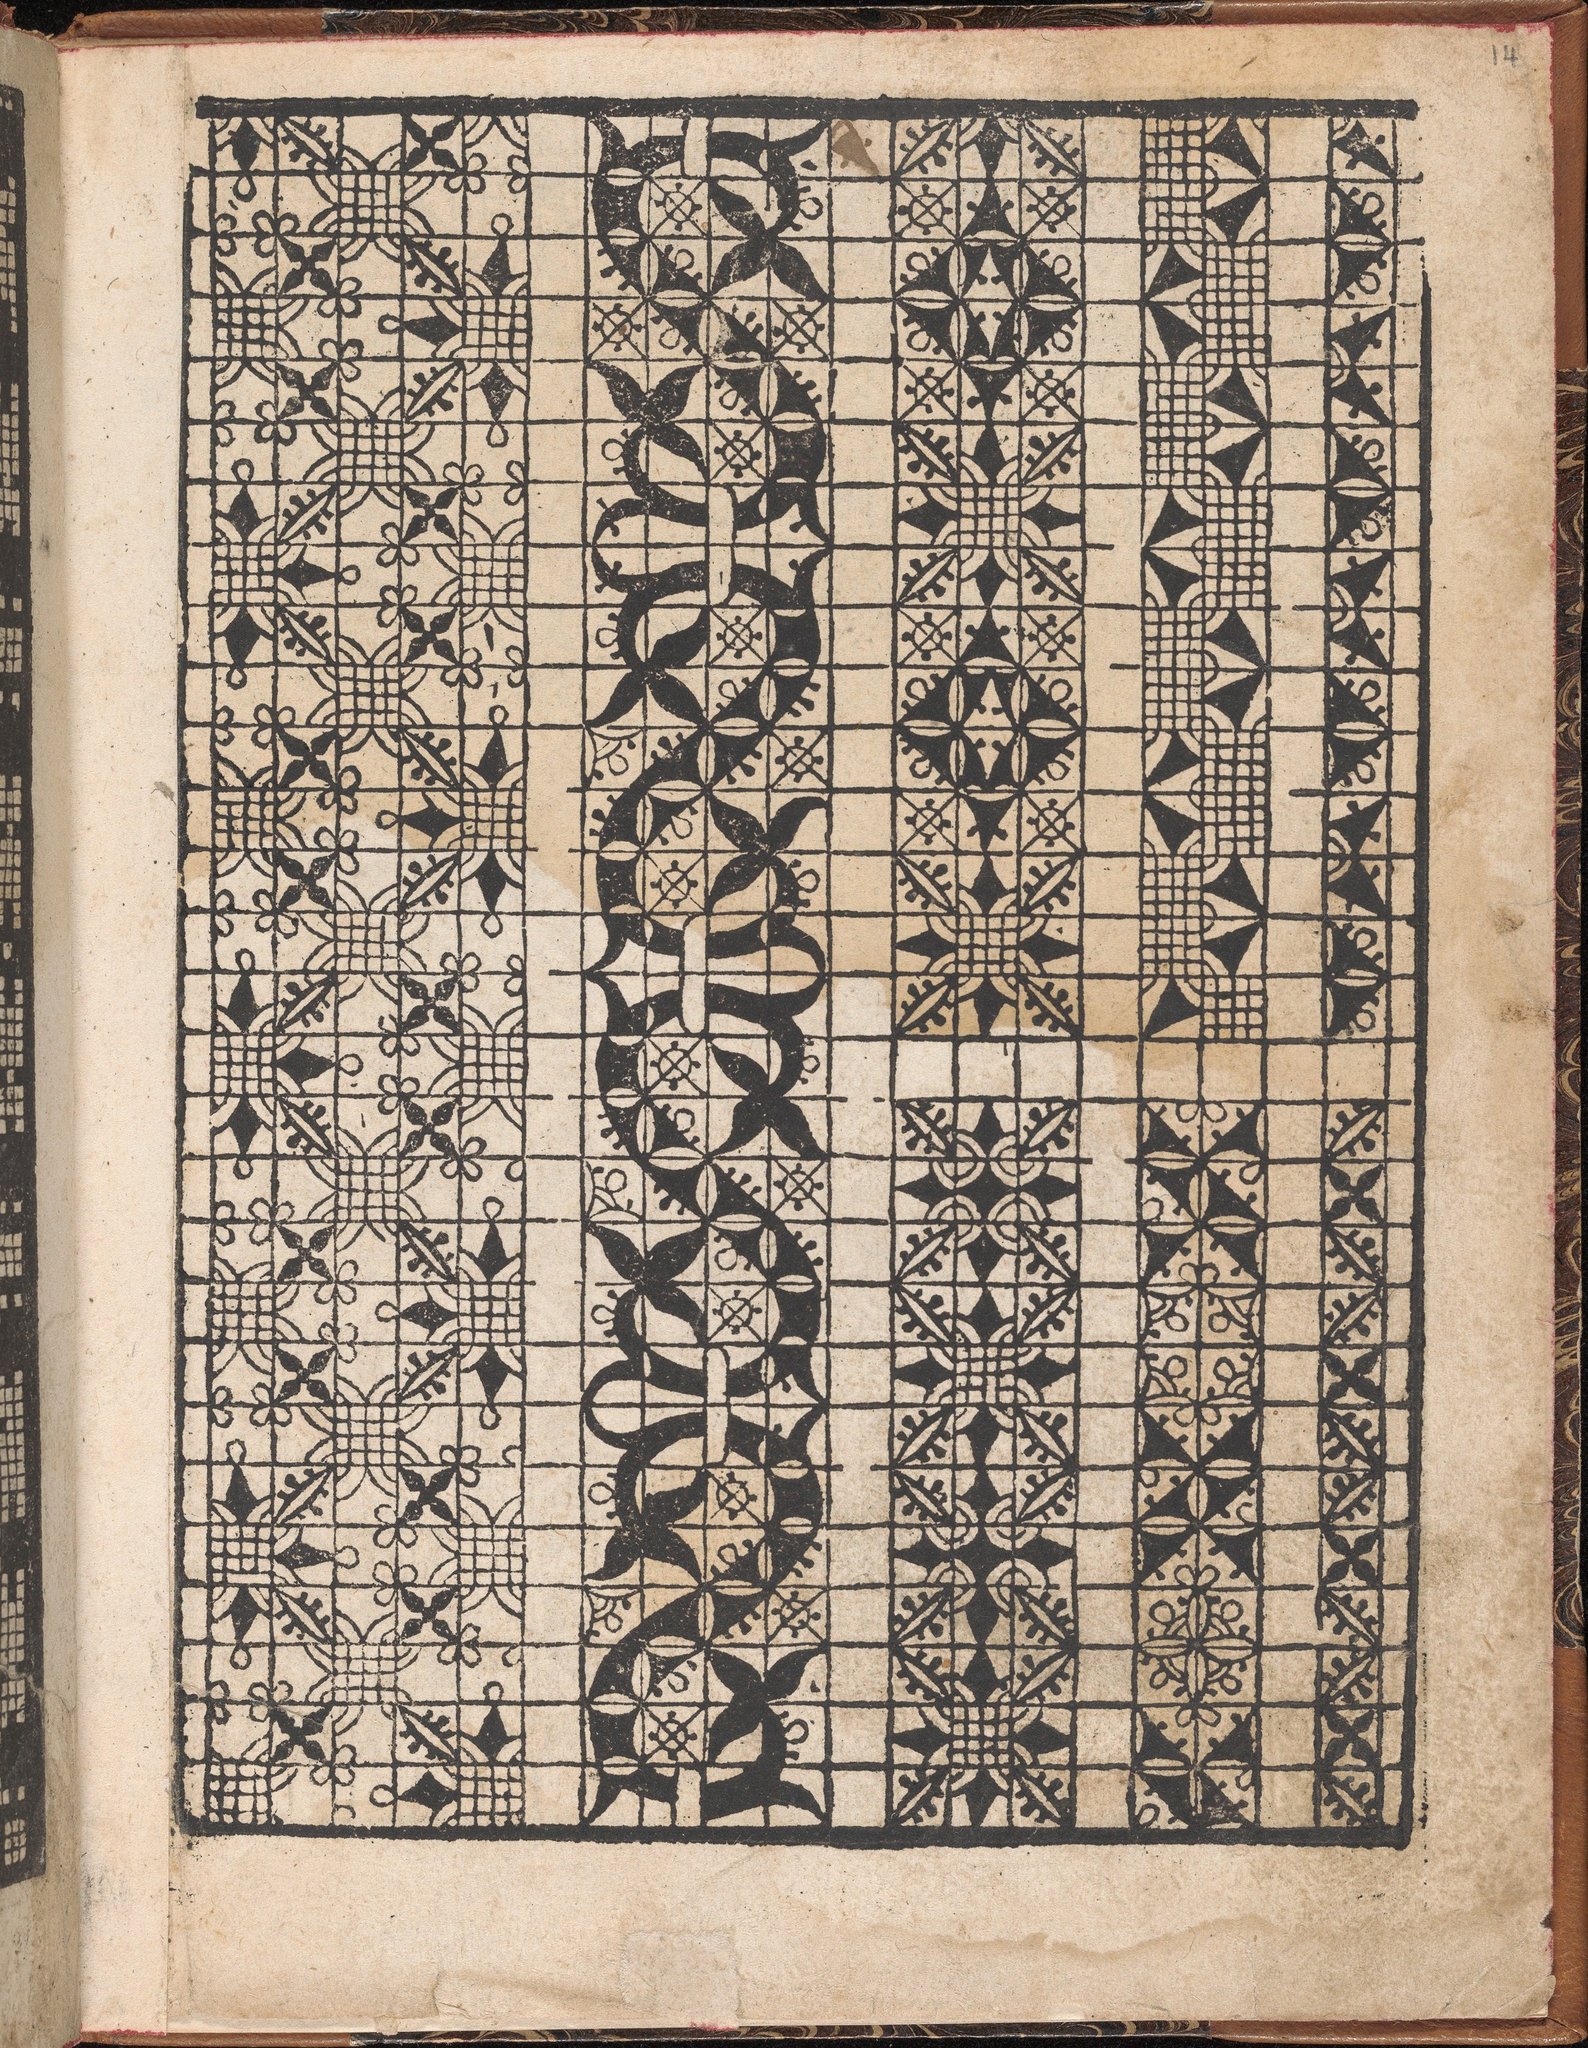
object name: book print ornament architecture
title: Spechio di pensieri delle belle et Virtudiose donne, page 12 (recto)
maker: matteo pagano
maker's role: publisher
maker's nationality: italian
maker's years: 1515-1588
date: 1546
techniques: woodcut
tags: ornament